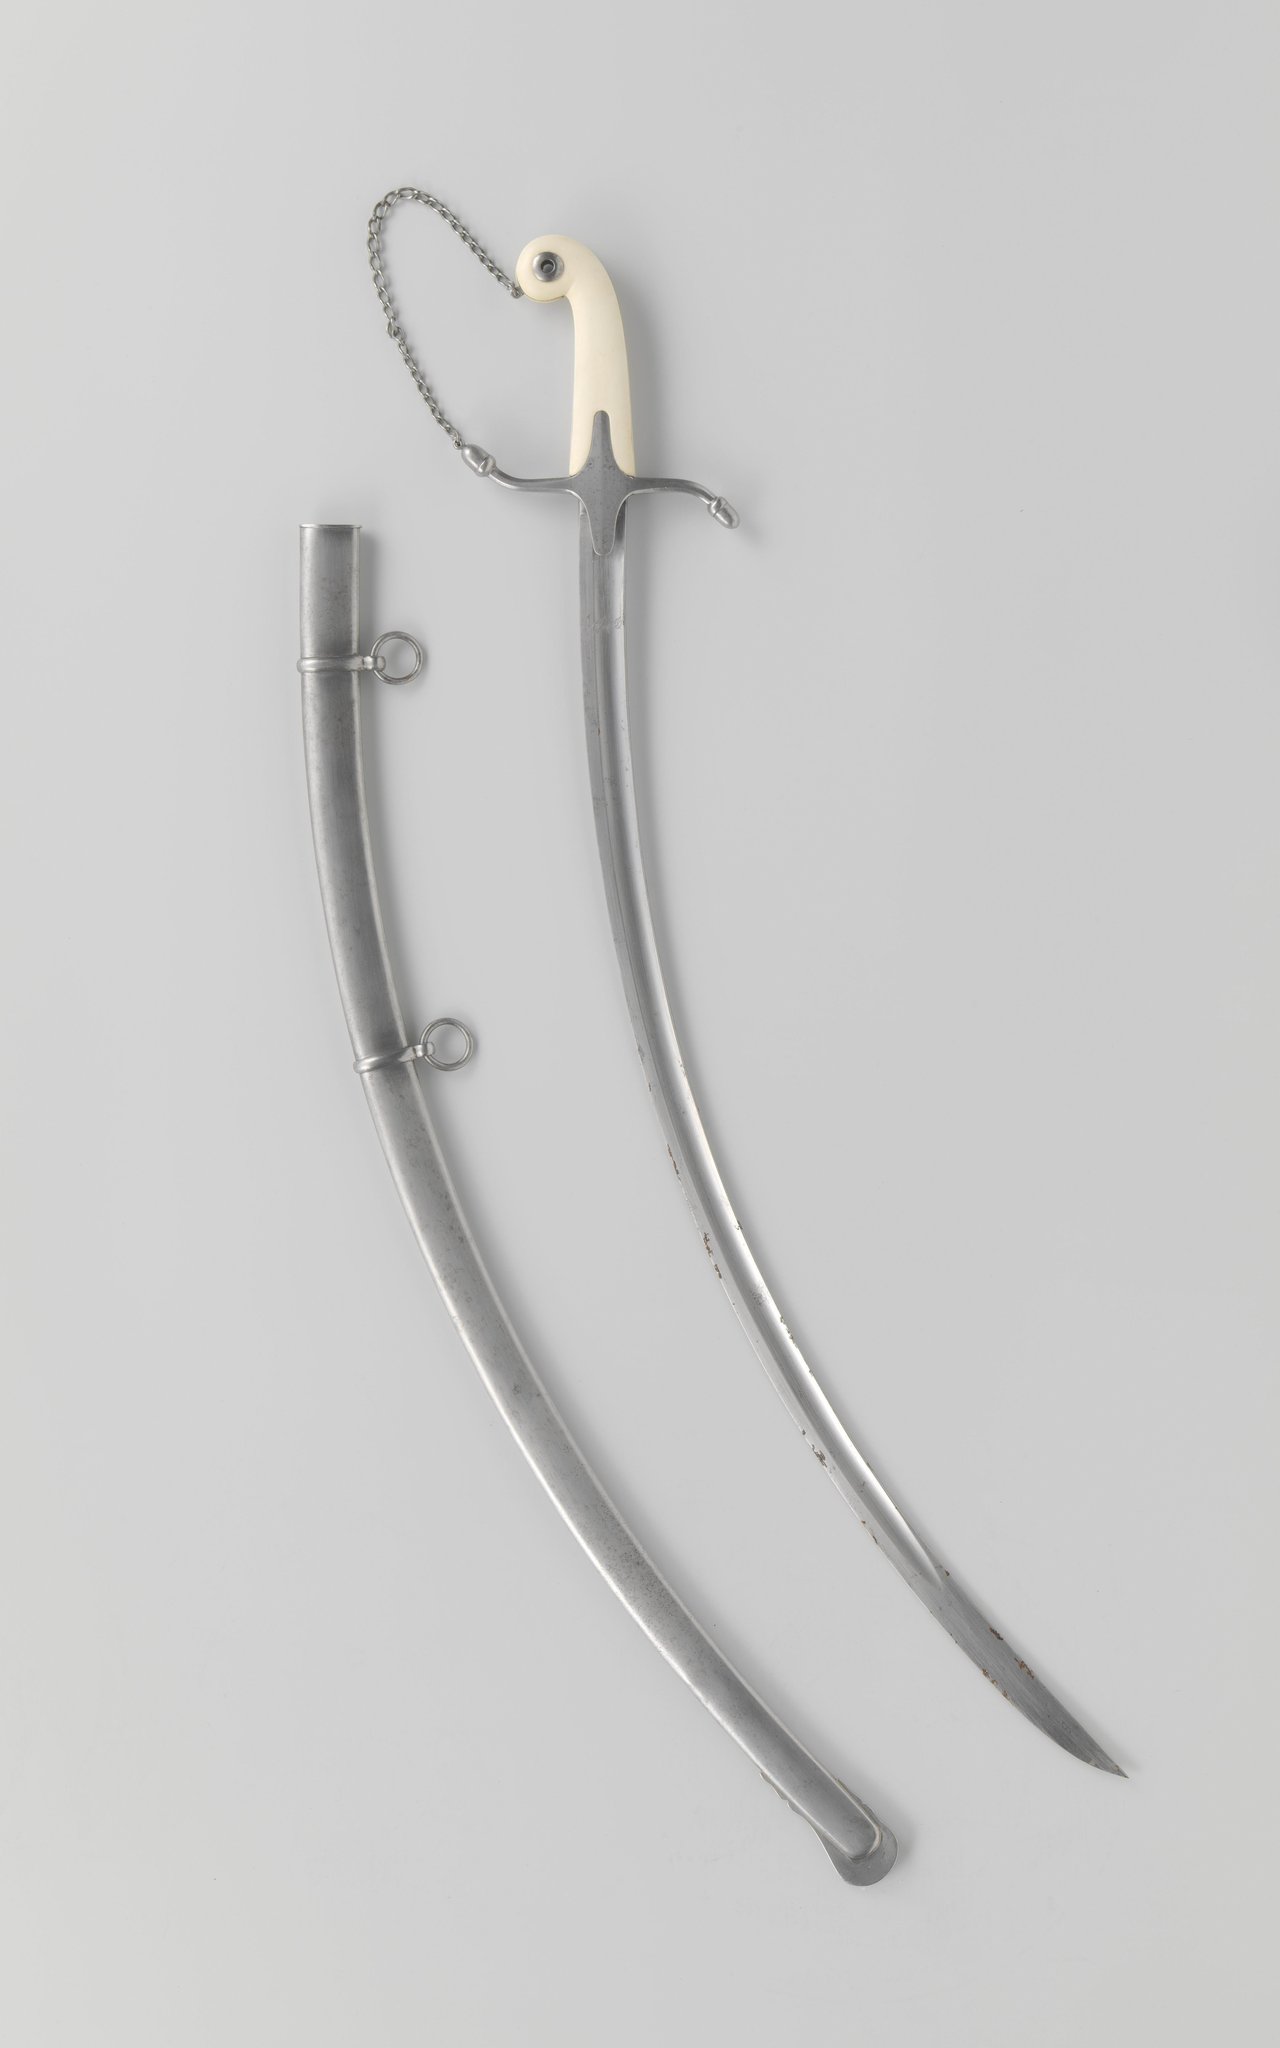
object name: sabre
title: Sabel met schede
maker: Anonymous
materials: iron, ivory, leather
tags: tobias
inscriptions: mark: ‘P.H. van Mansveld’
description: Turks model sabel met ijzeren stootbeugel en ivoren greep met ketting. Gemerkt P.H. van Mansveld. Met ijzeren schede, ijzeren ringen en leren koppel. Afkomstig van luitenant Tobias van het 6e Regiment Huzaren.